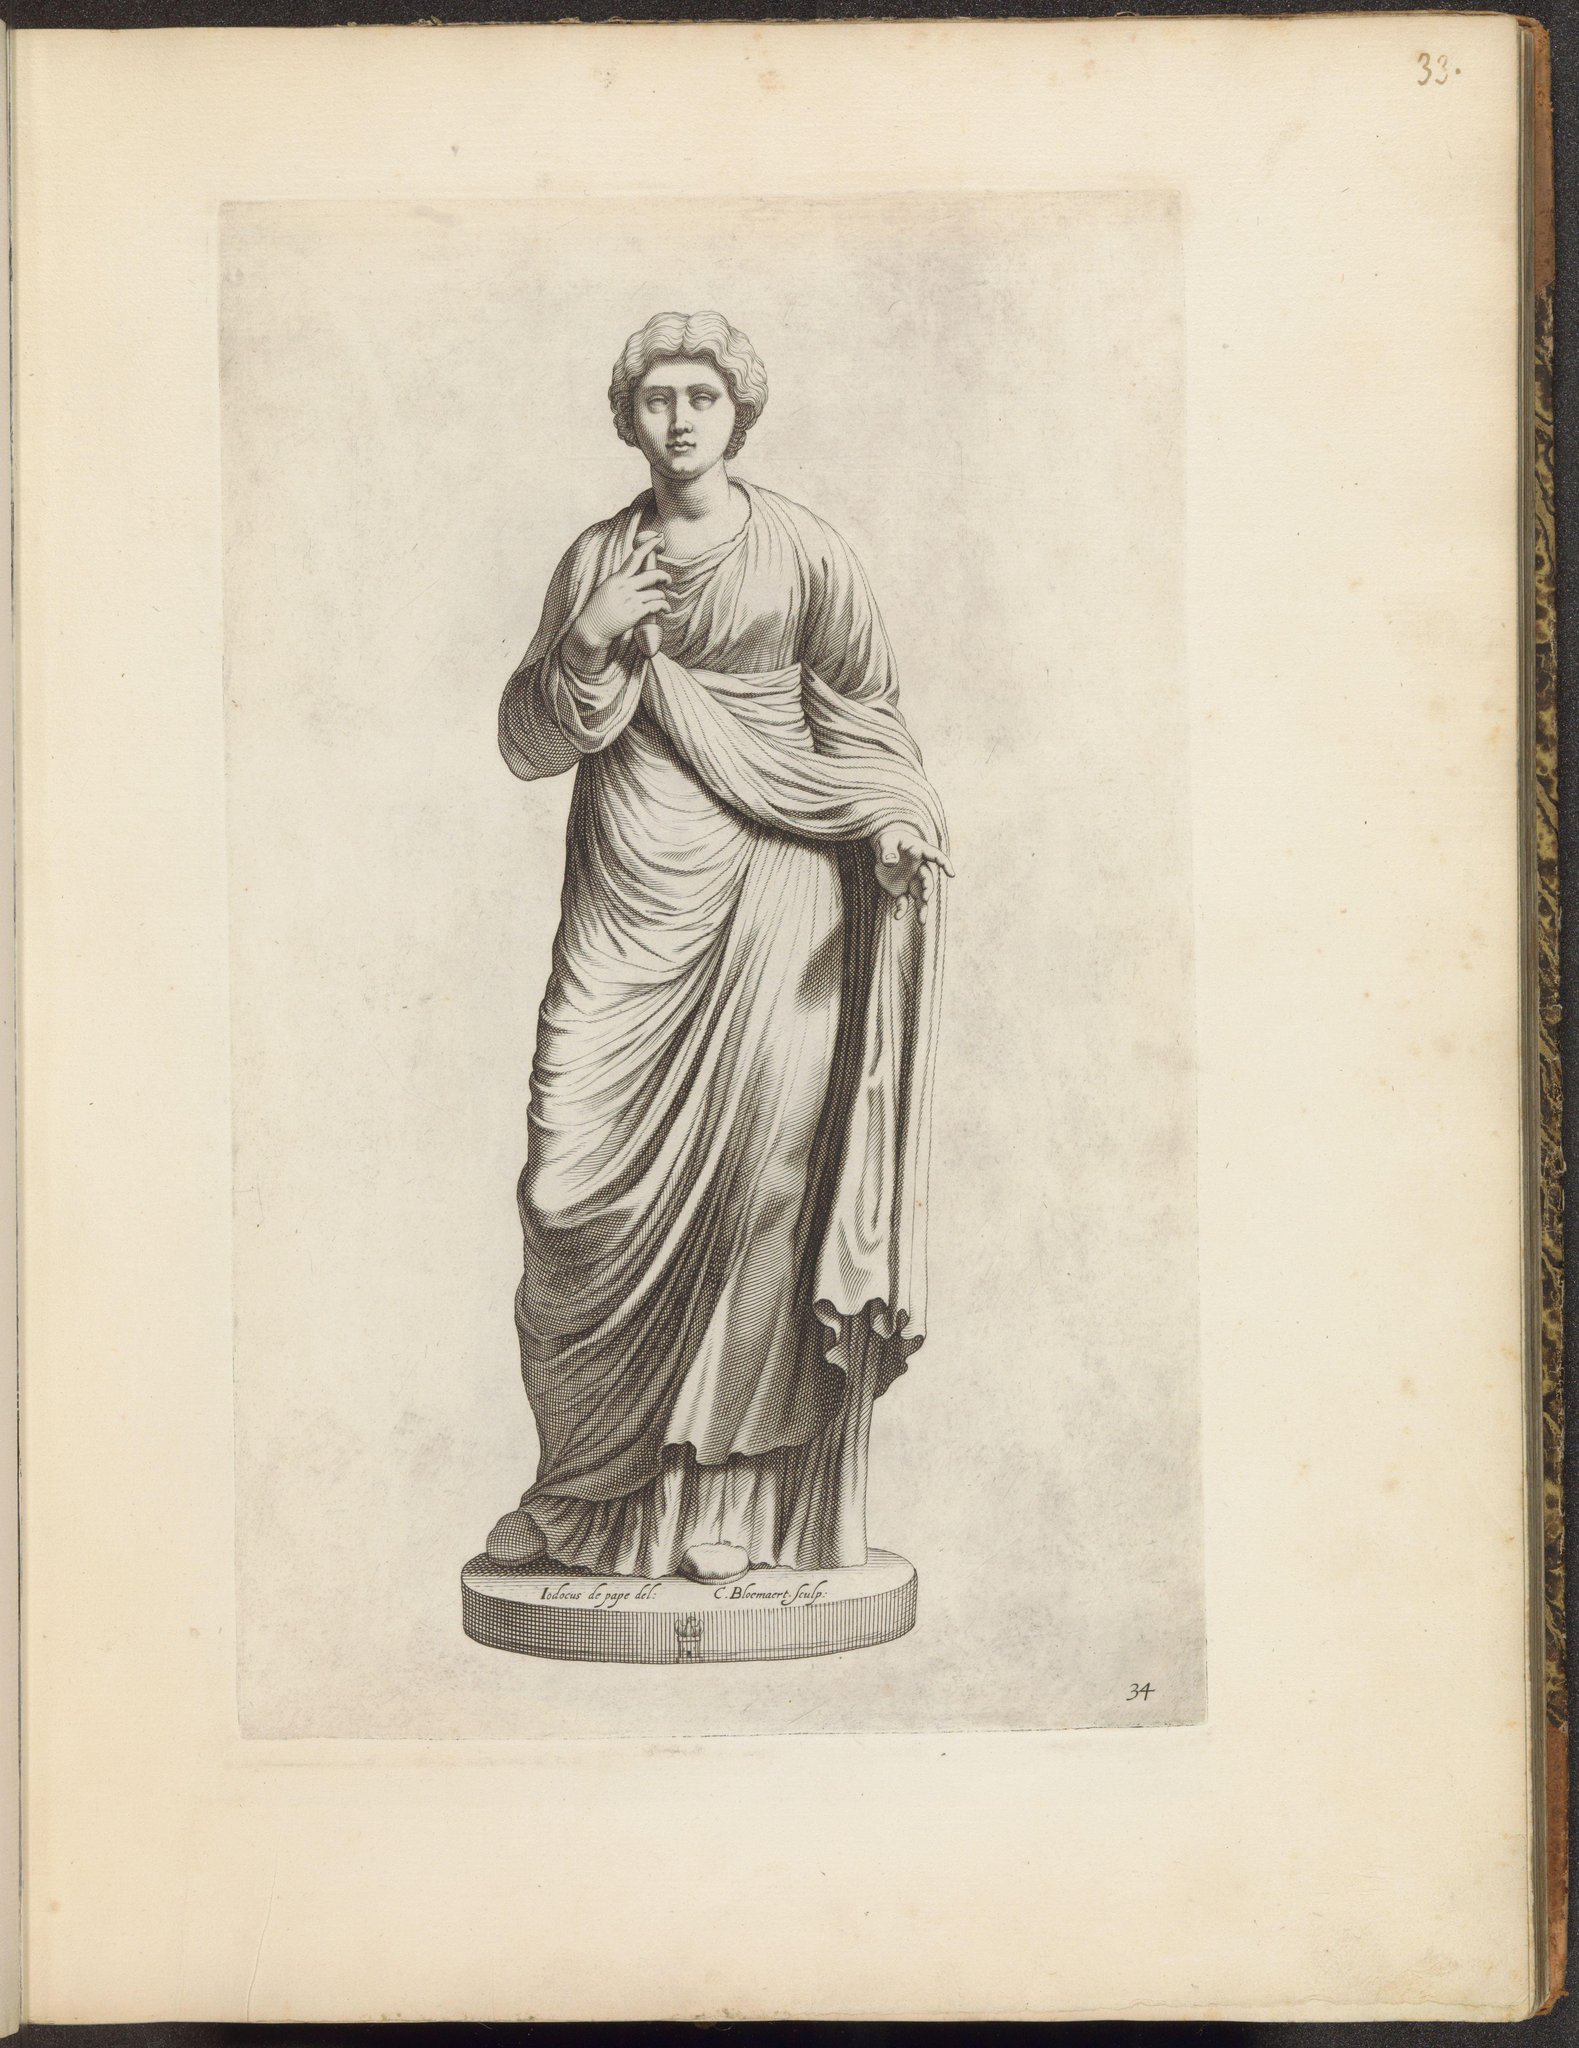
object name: album leaf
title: Standbeeld van een vrouw met Romeinse kleding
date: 1636-1647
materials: paper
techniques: engraving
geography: rome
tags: piece of sculpture, reproduction of a piece of sculpture, classical history (+ full length)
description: Een beeld van een vrouw in Romeinse kleding. In haar hand houdt ze een spoel. Op de basis het wapenschild van Vincenzo Giustiniani. Prent maakt deel uit van een album met een serie prenten naar de sculpturen in de verzameling in de Galleria Giustiniani te Rome.